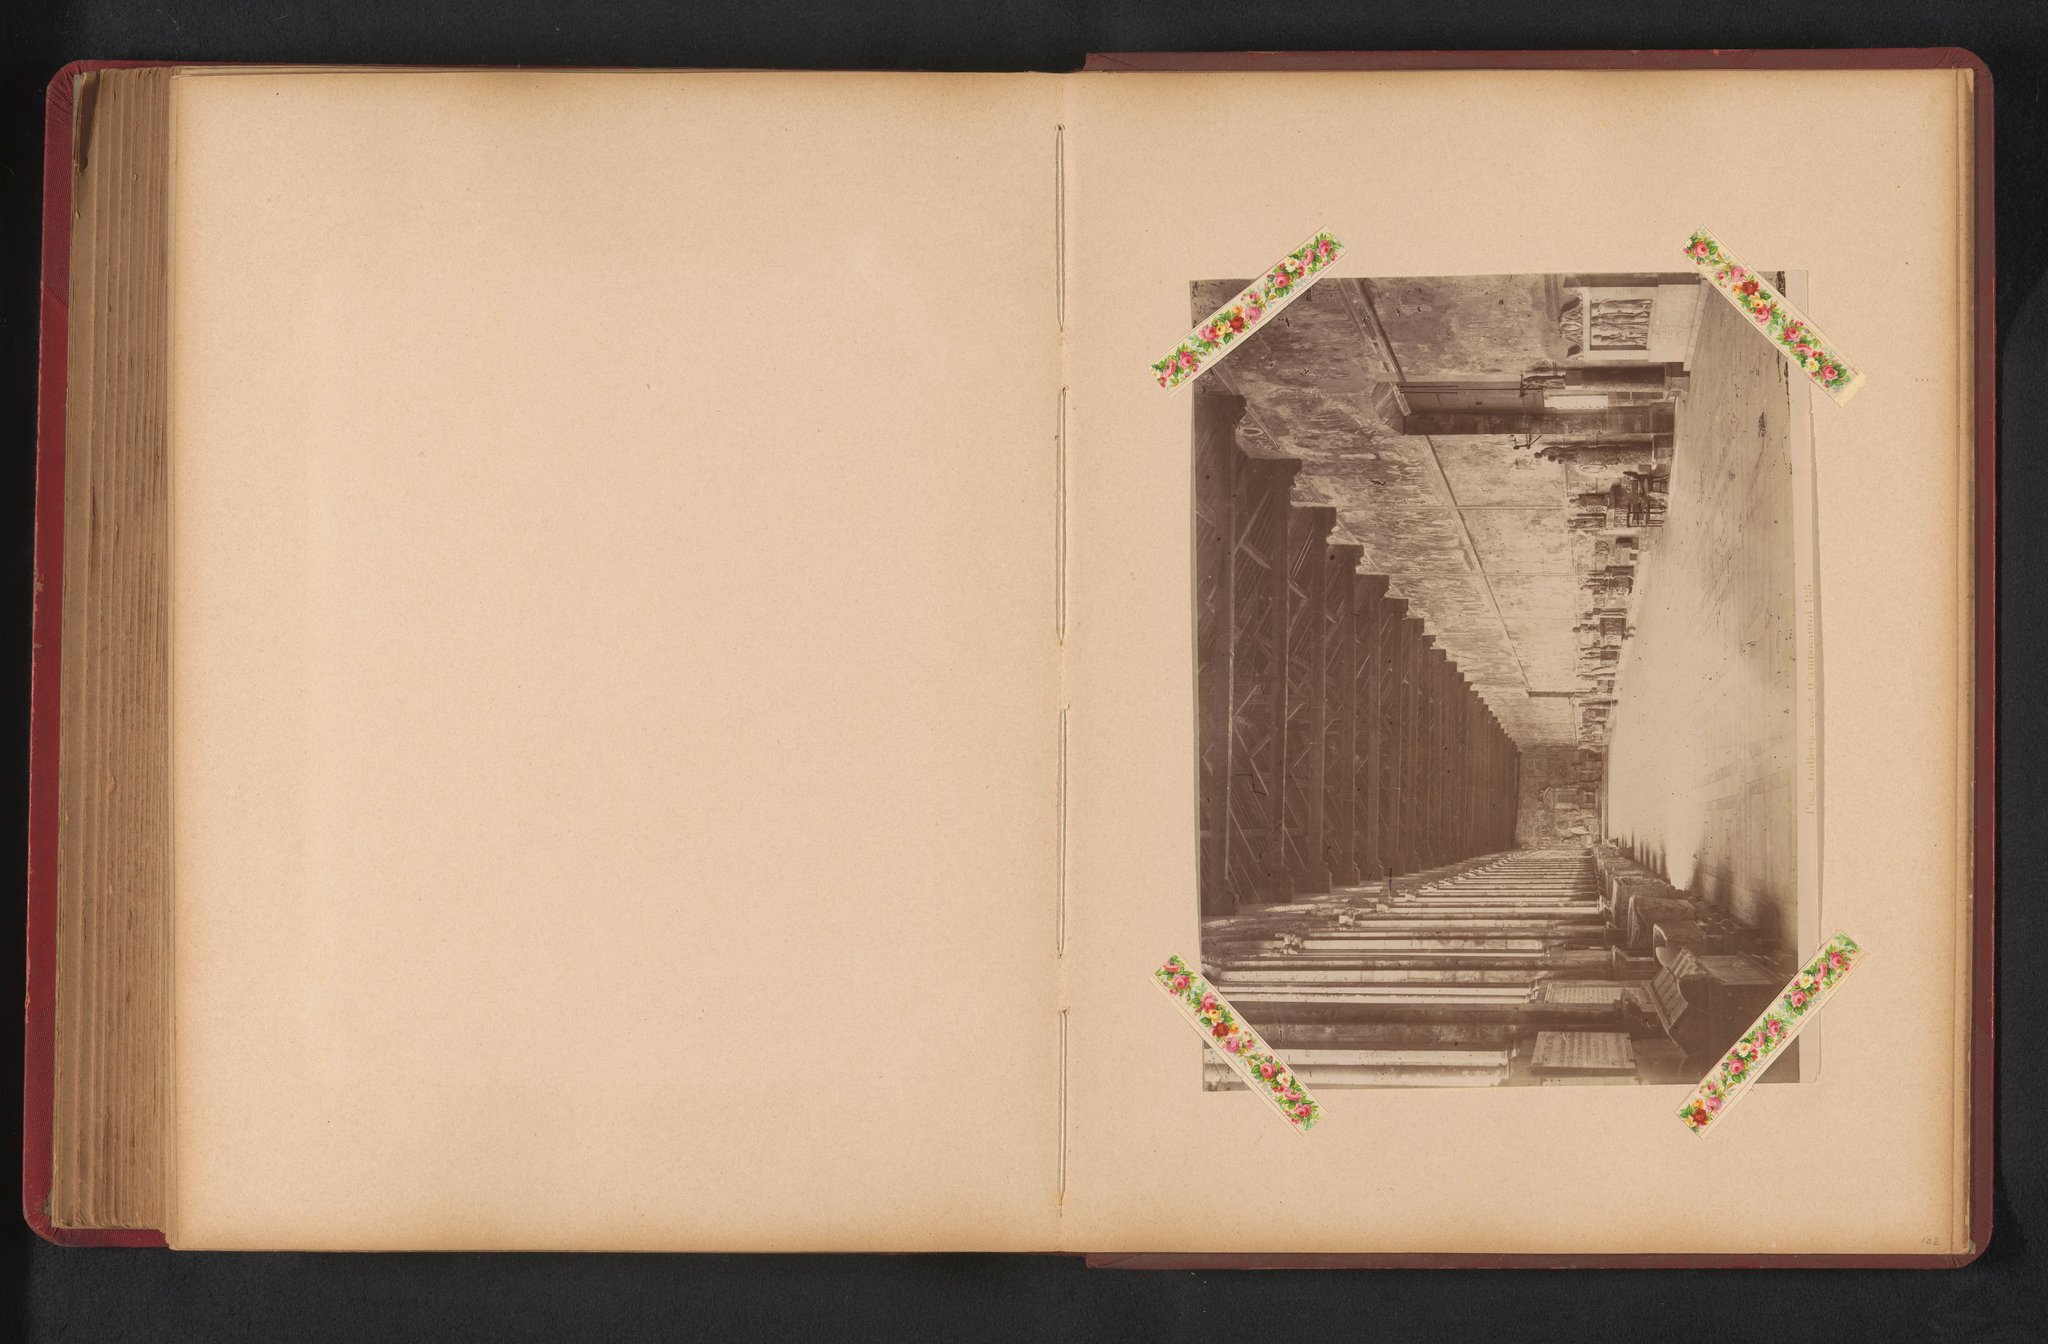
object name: photograph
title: Pisa. Galleria ovest (Camposante)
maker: Anonymous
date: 1860-1900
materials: photographic support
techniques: albumen print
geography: pisa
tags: colonnade, painting (including book-illumination, miniature-painting) (+ plaster ~ arts), cemetery, park-like burying ground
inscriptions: number: ‘1[...]’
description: Onderdeel van Fotoalbum met opnames van bezienswaardigheden in Italiaanse steden en van kunstwerken.